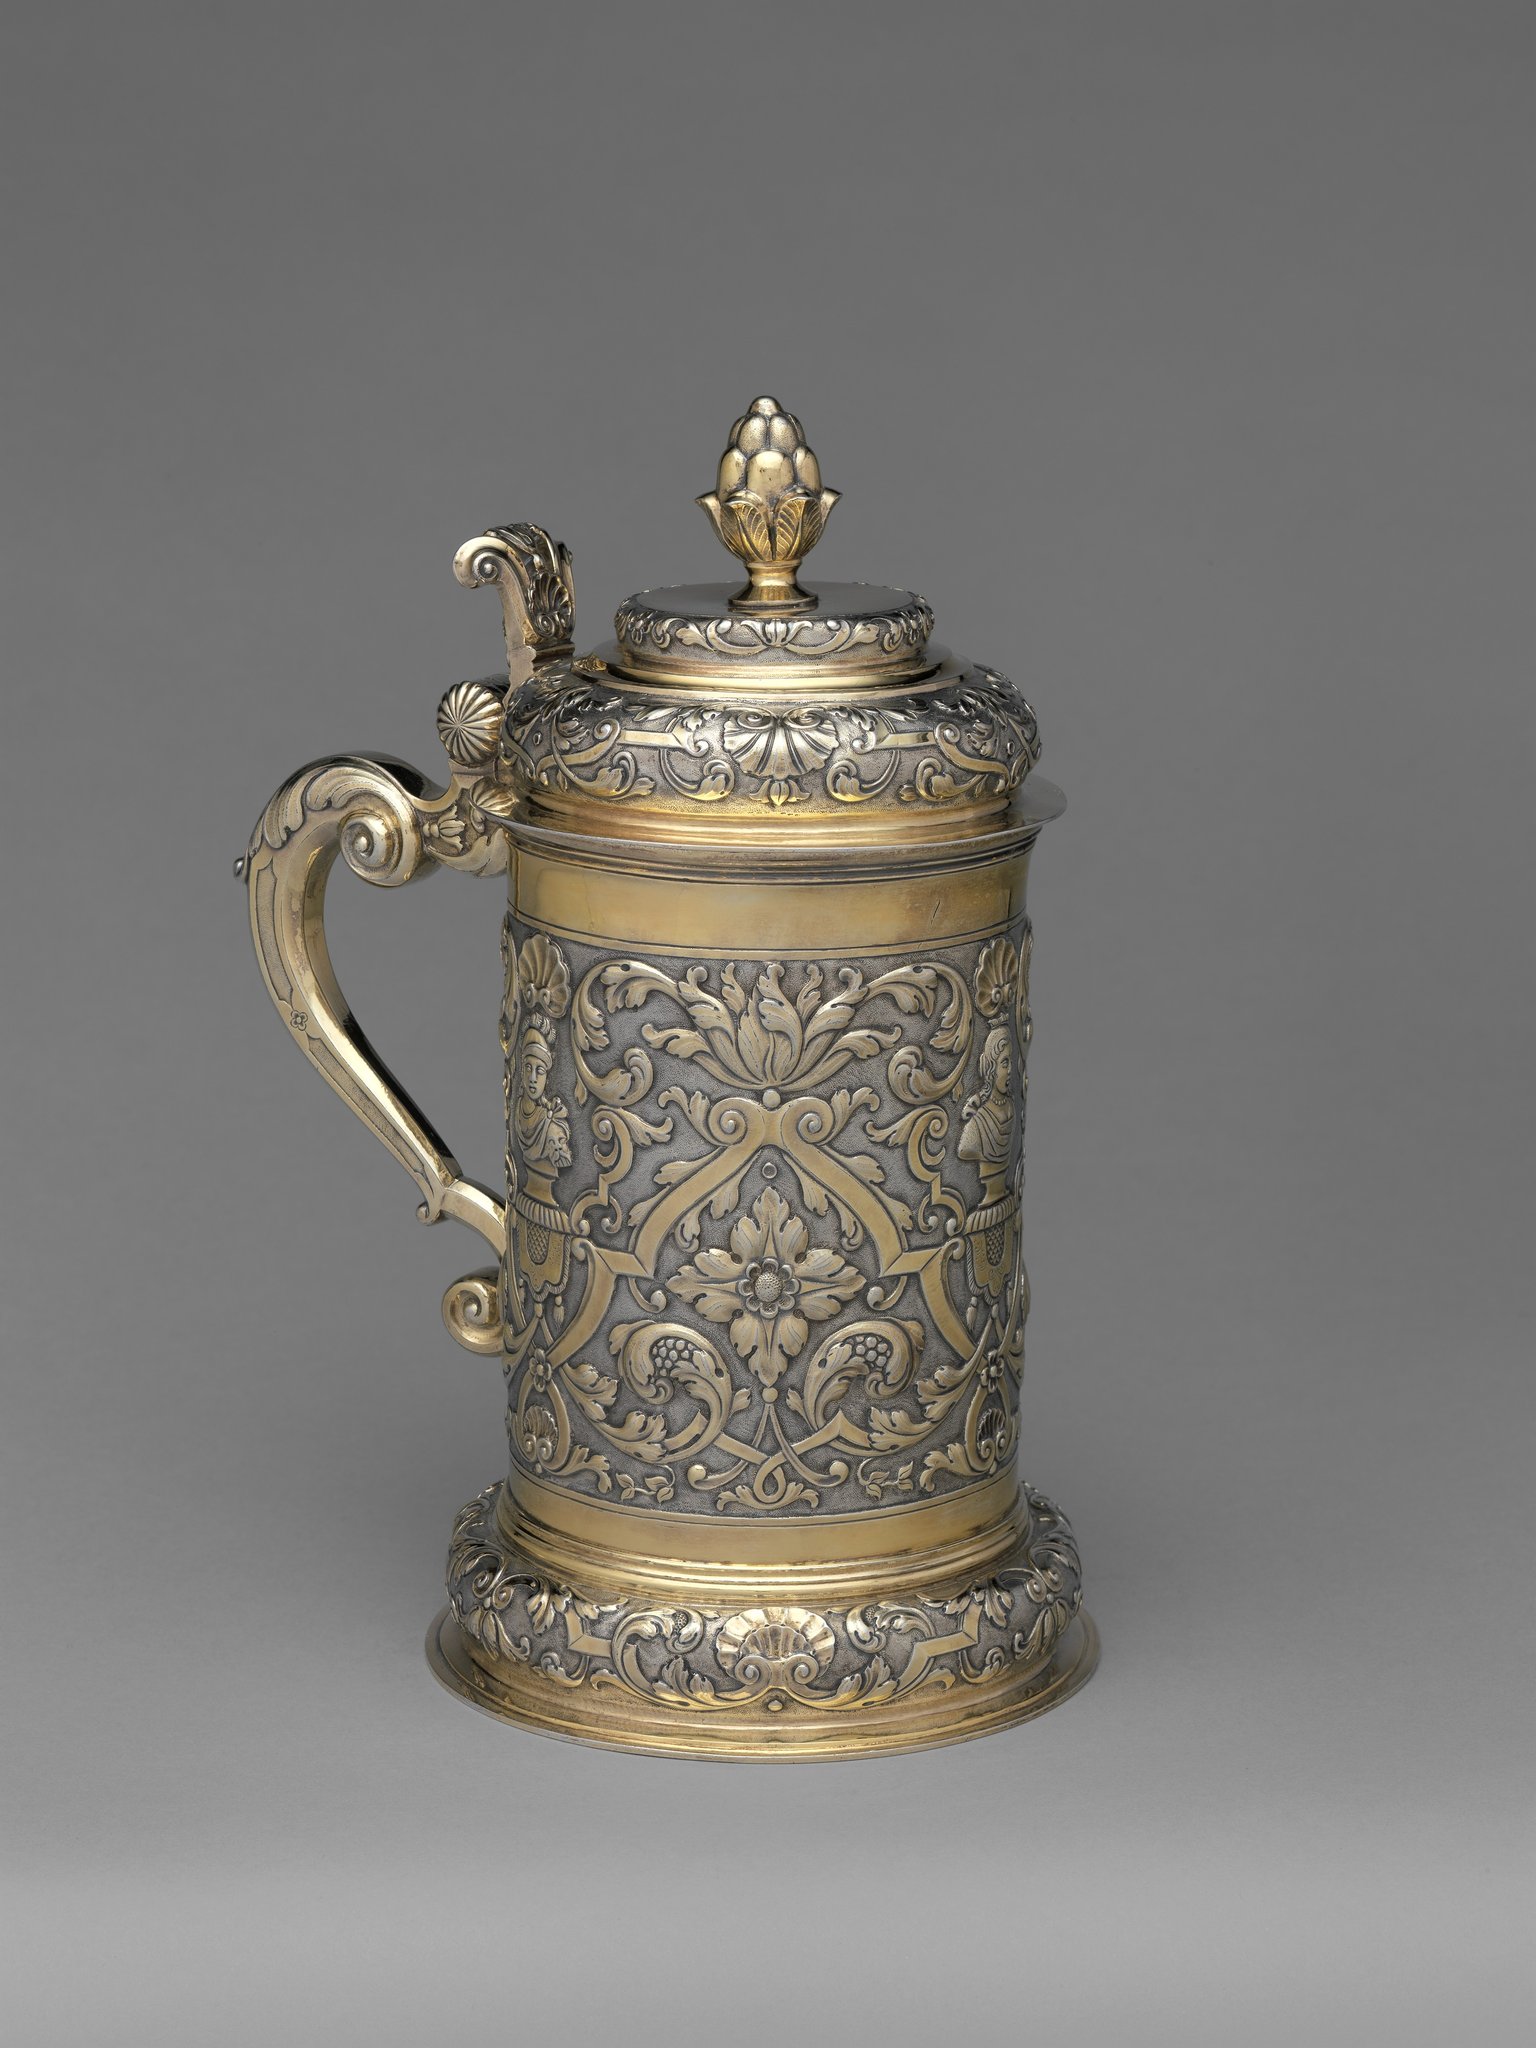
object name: tankard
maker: michael may ii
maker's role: maker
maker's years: 1731-1776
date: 1734-1766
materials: gilt silver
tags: flowers